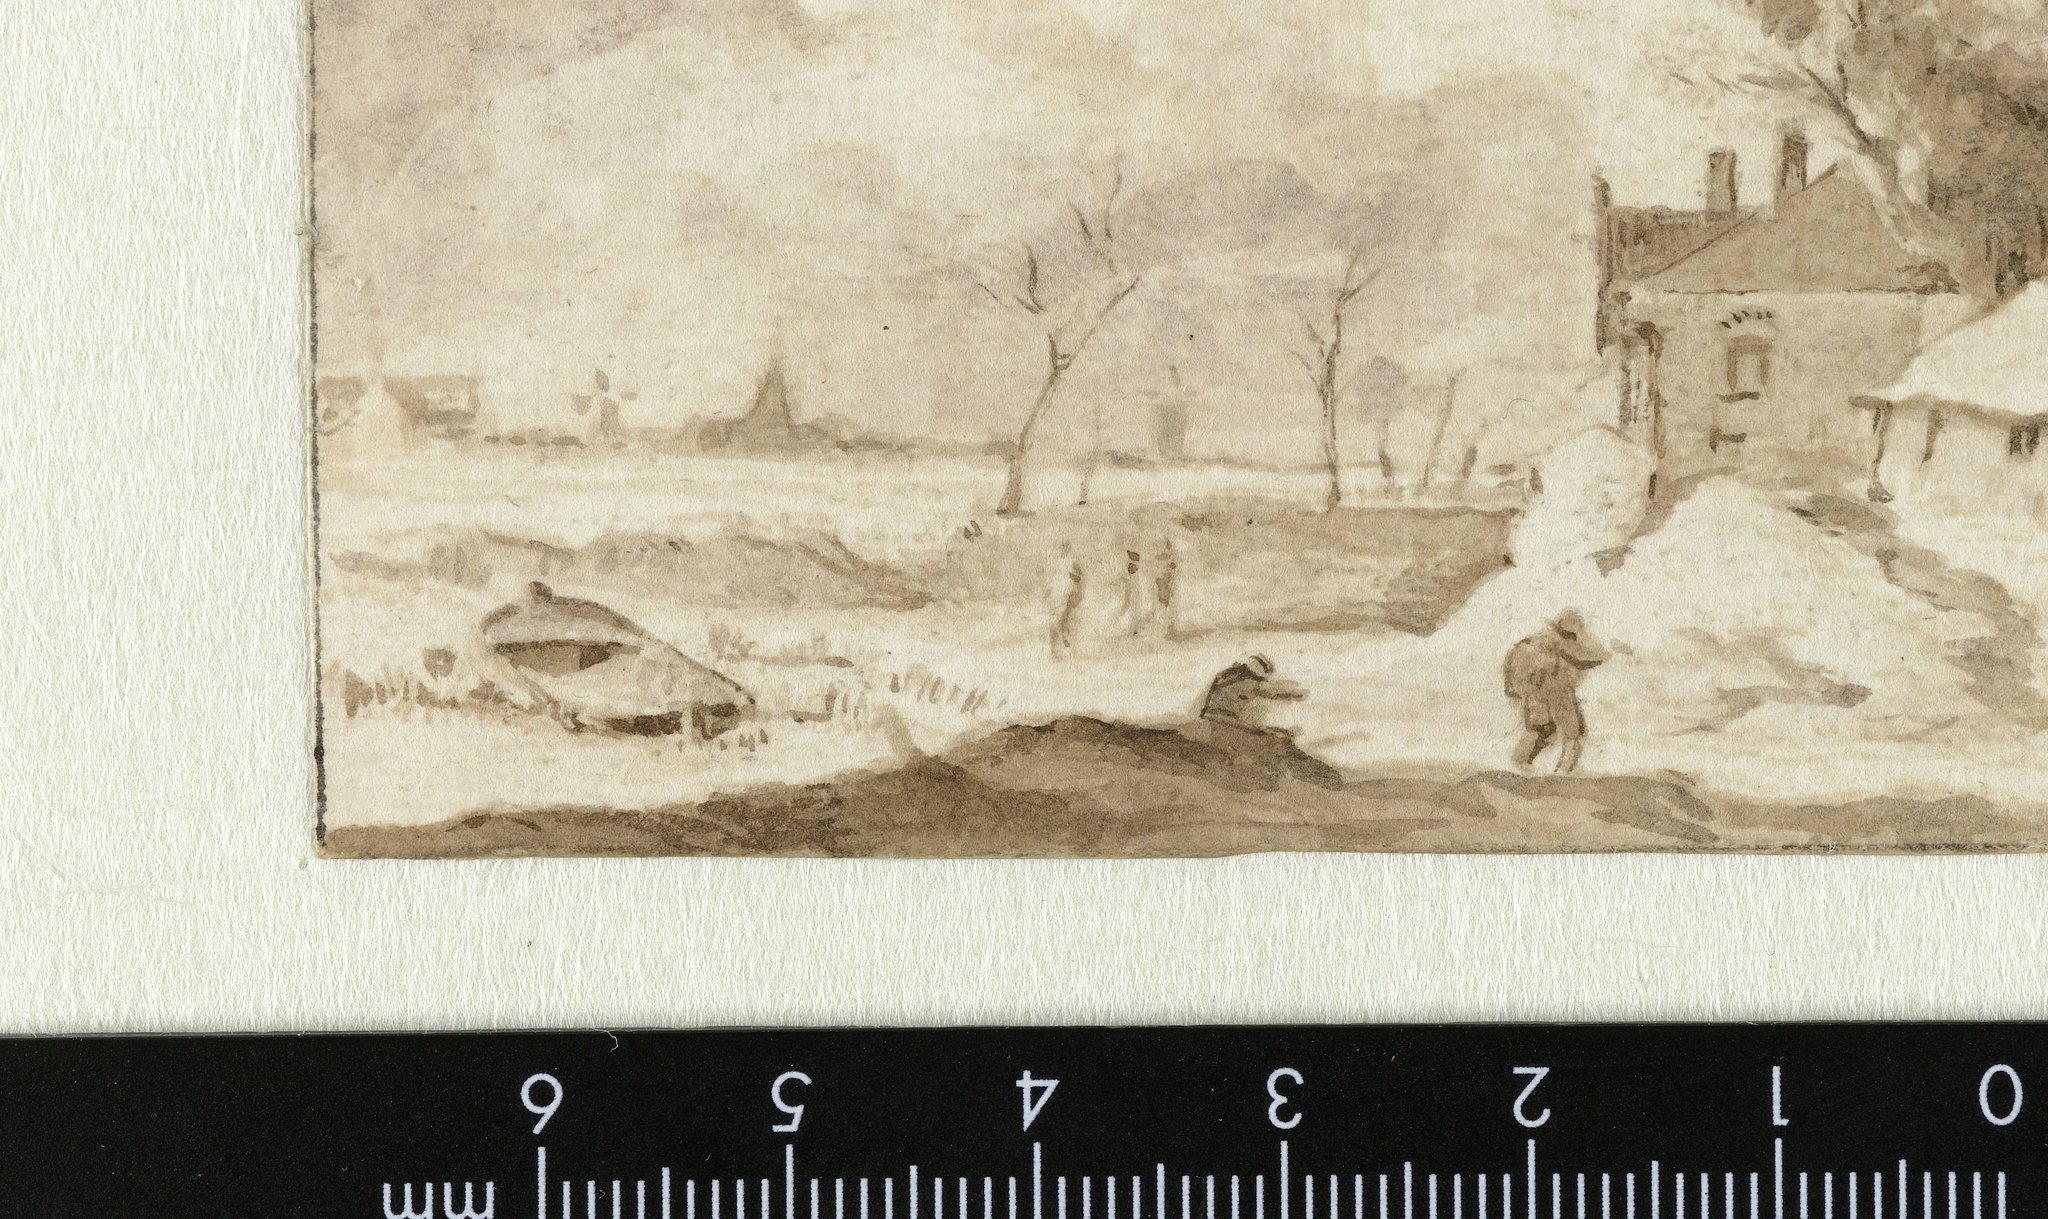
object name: drawing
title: Landschap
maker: allaert van everdingen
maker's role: draughtsman, painter, print maker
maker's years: 1621-1675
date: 1631-1675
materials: ink, paper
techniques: brush, pen